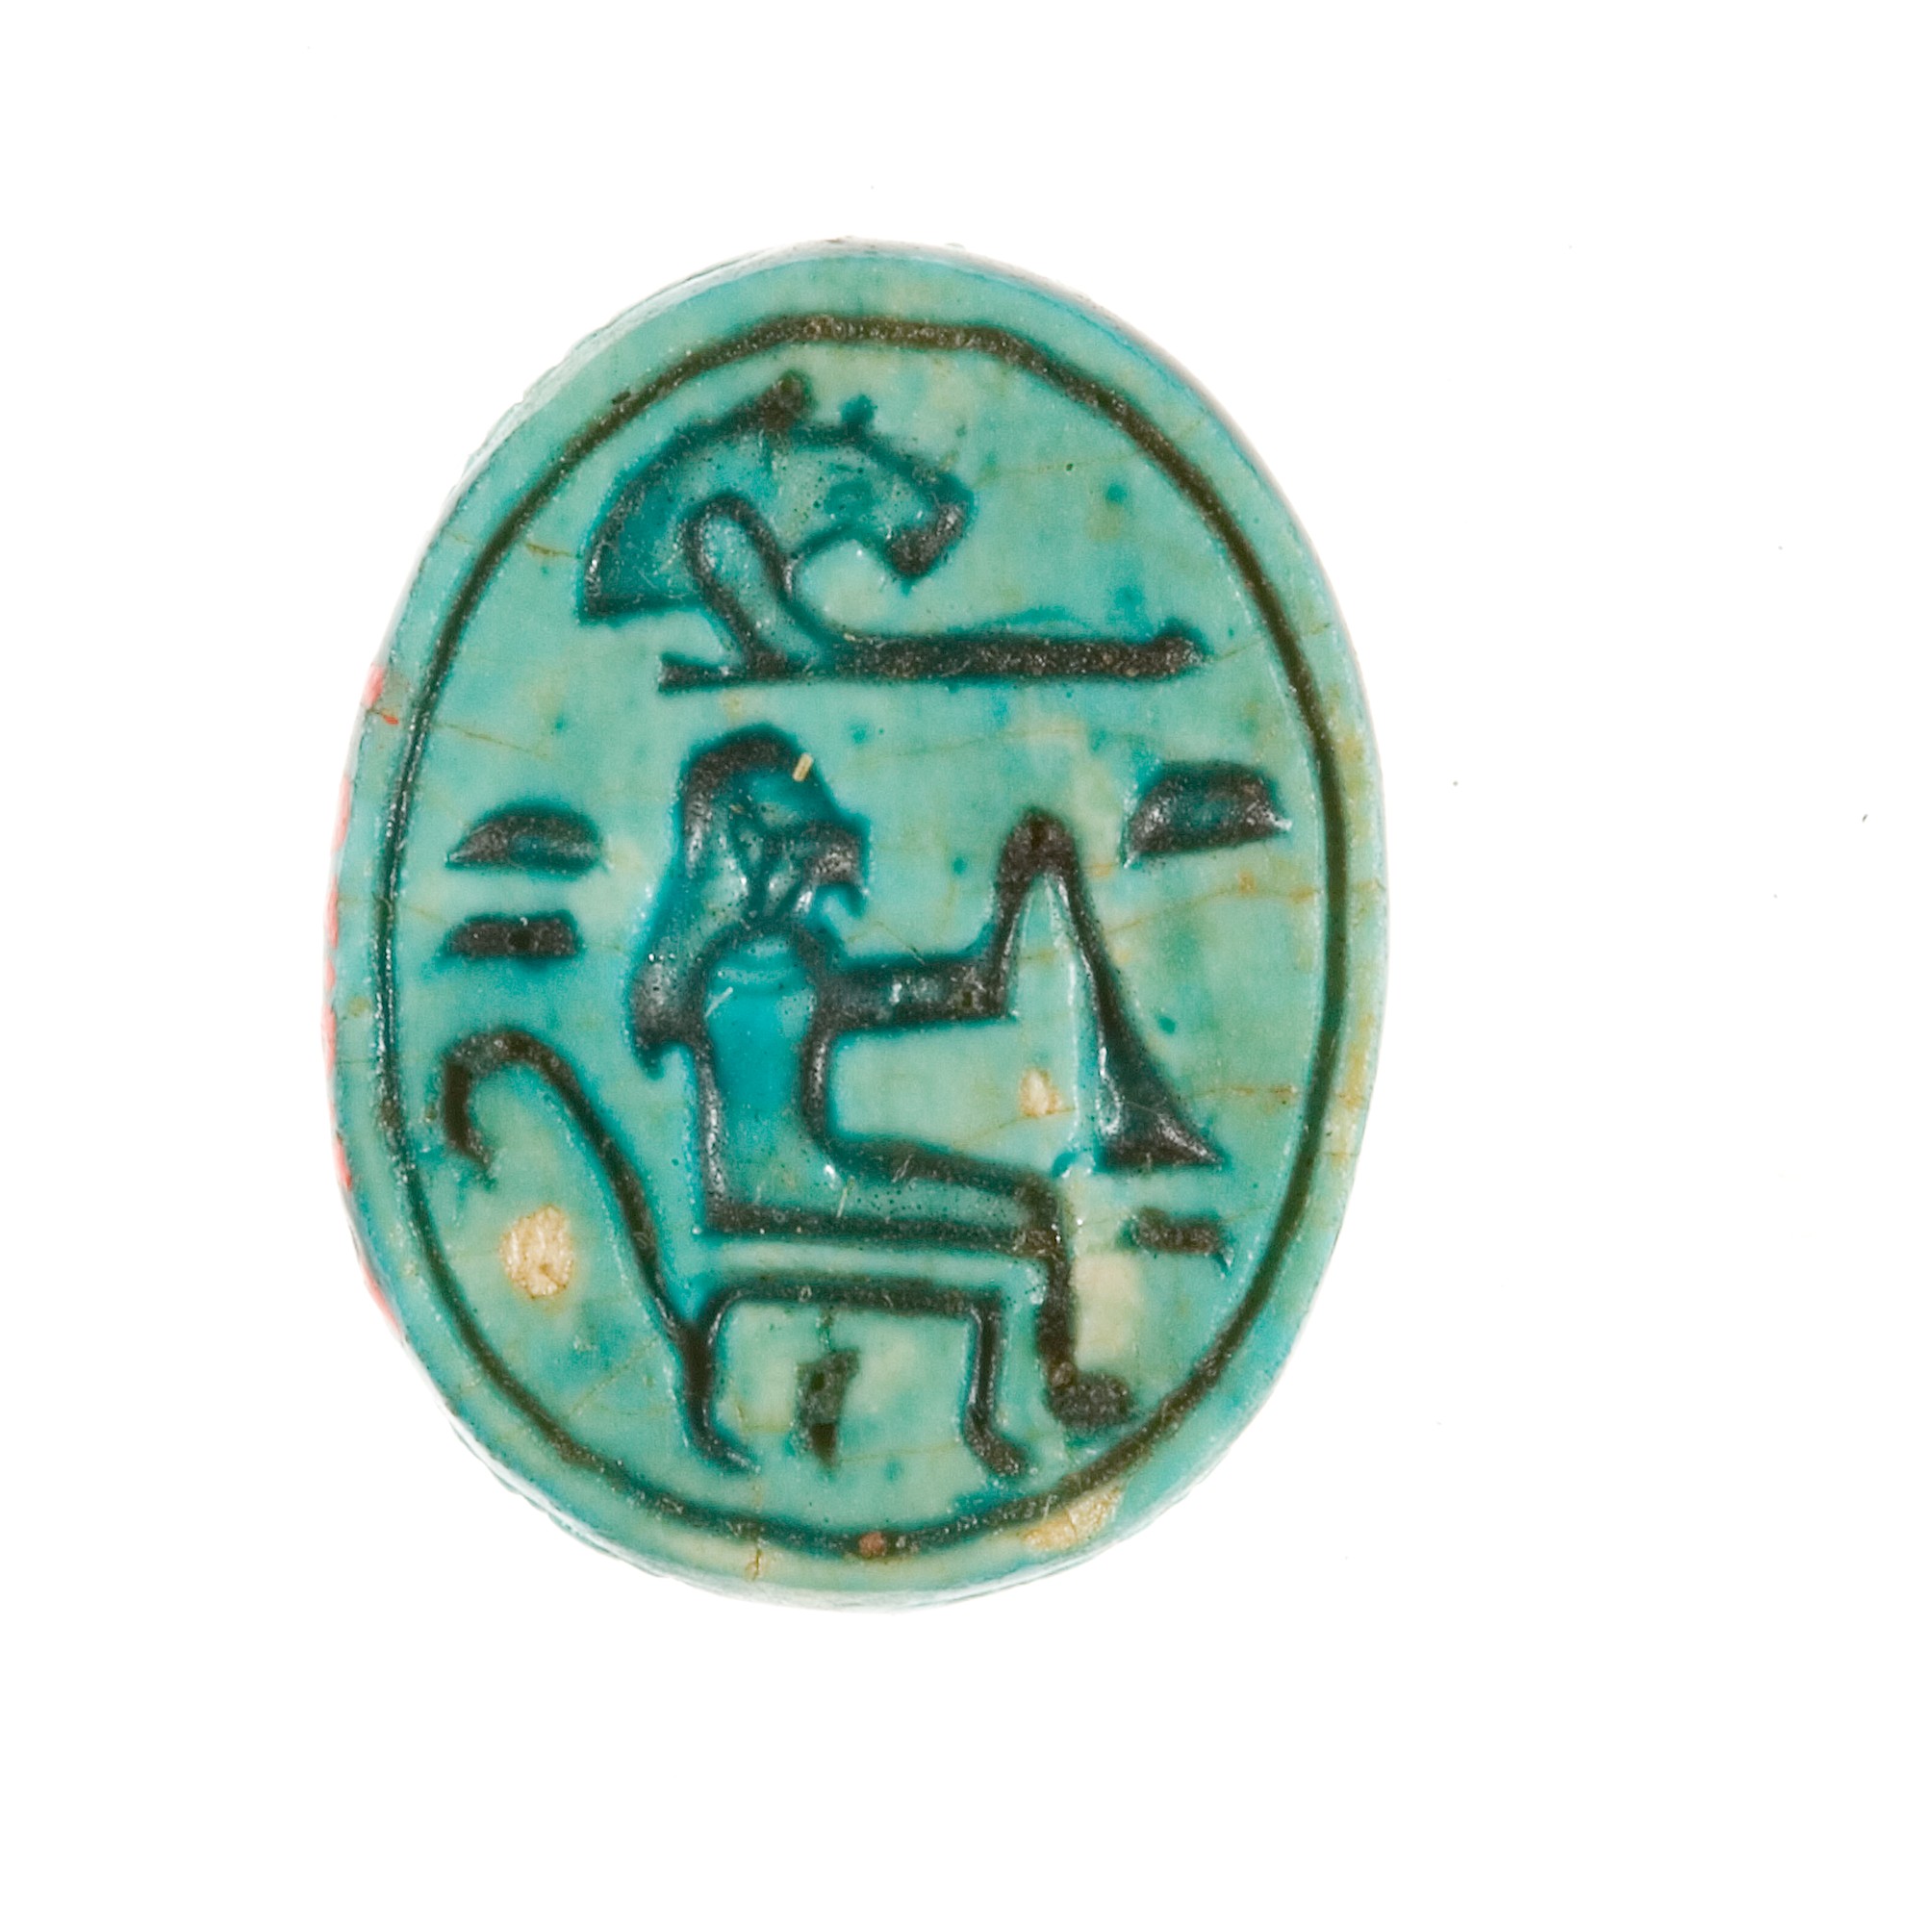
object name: scarab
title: Scarab Inscribed for Hatshepsut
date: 1479-1458 BCE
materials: stone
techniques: glazing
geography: egypt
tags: hieroglyphs,scarabs